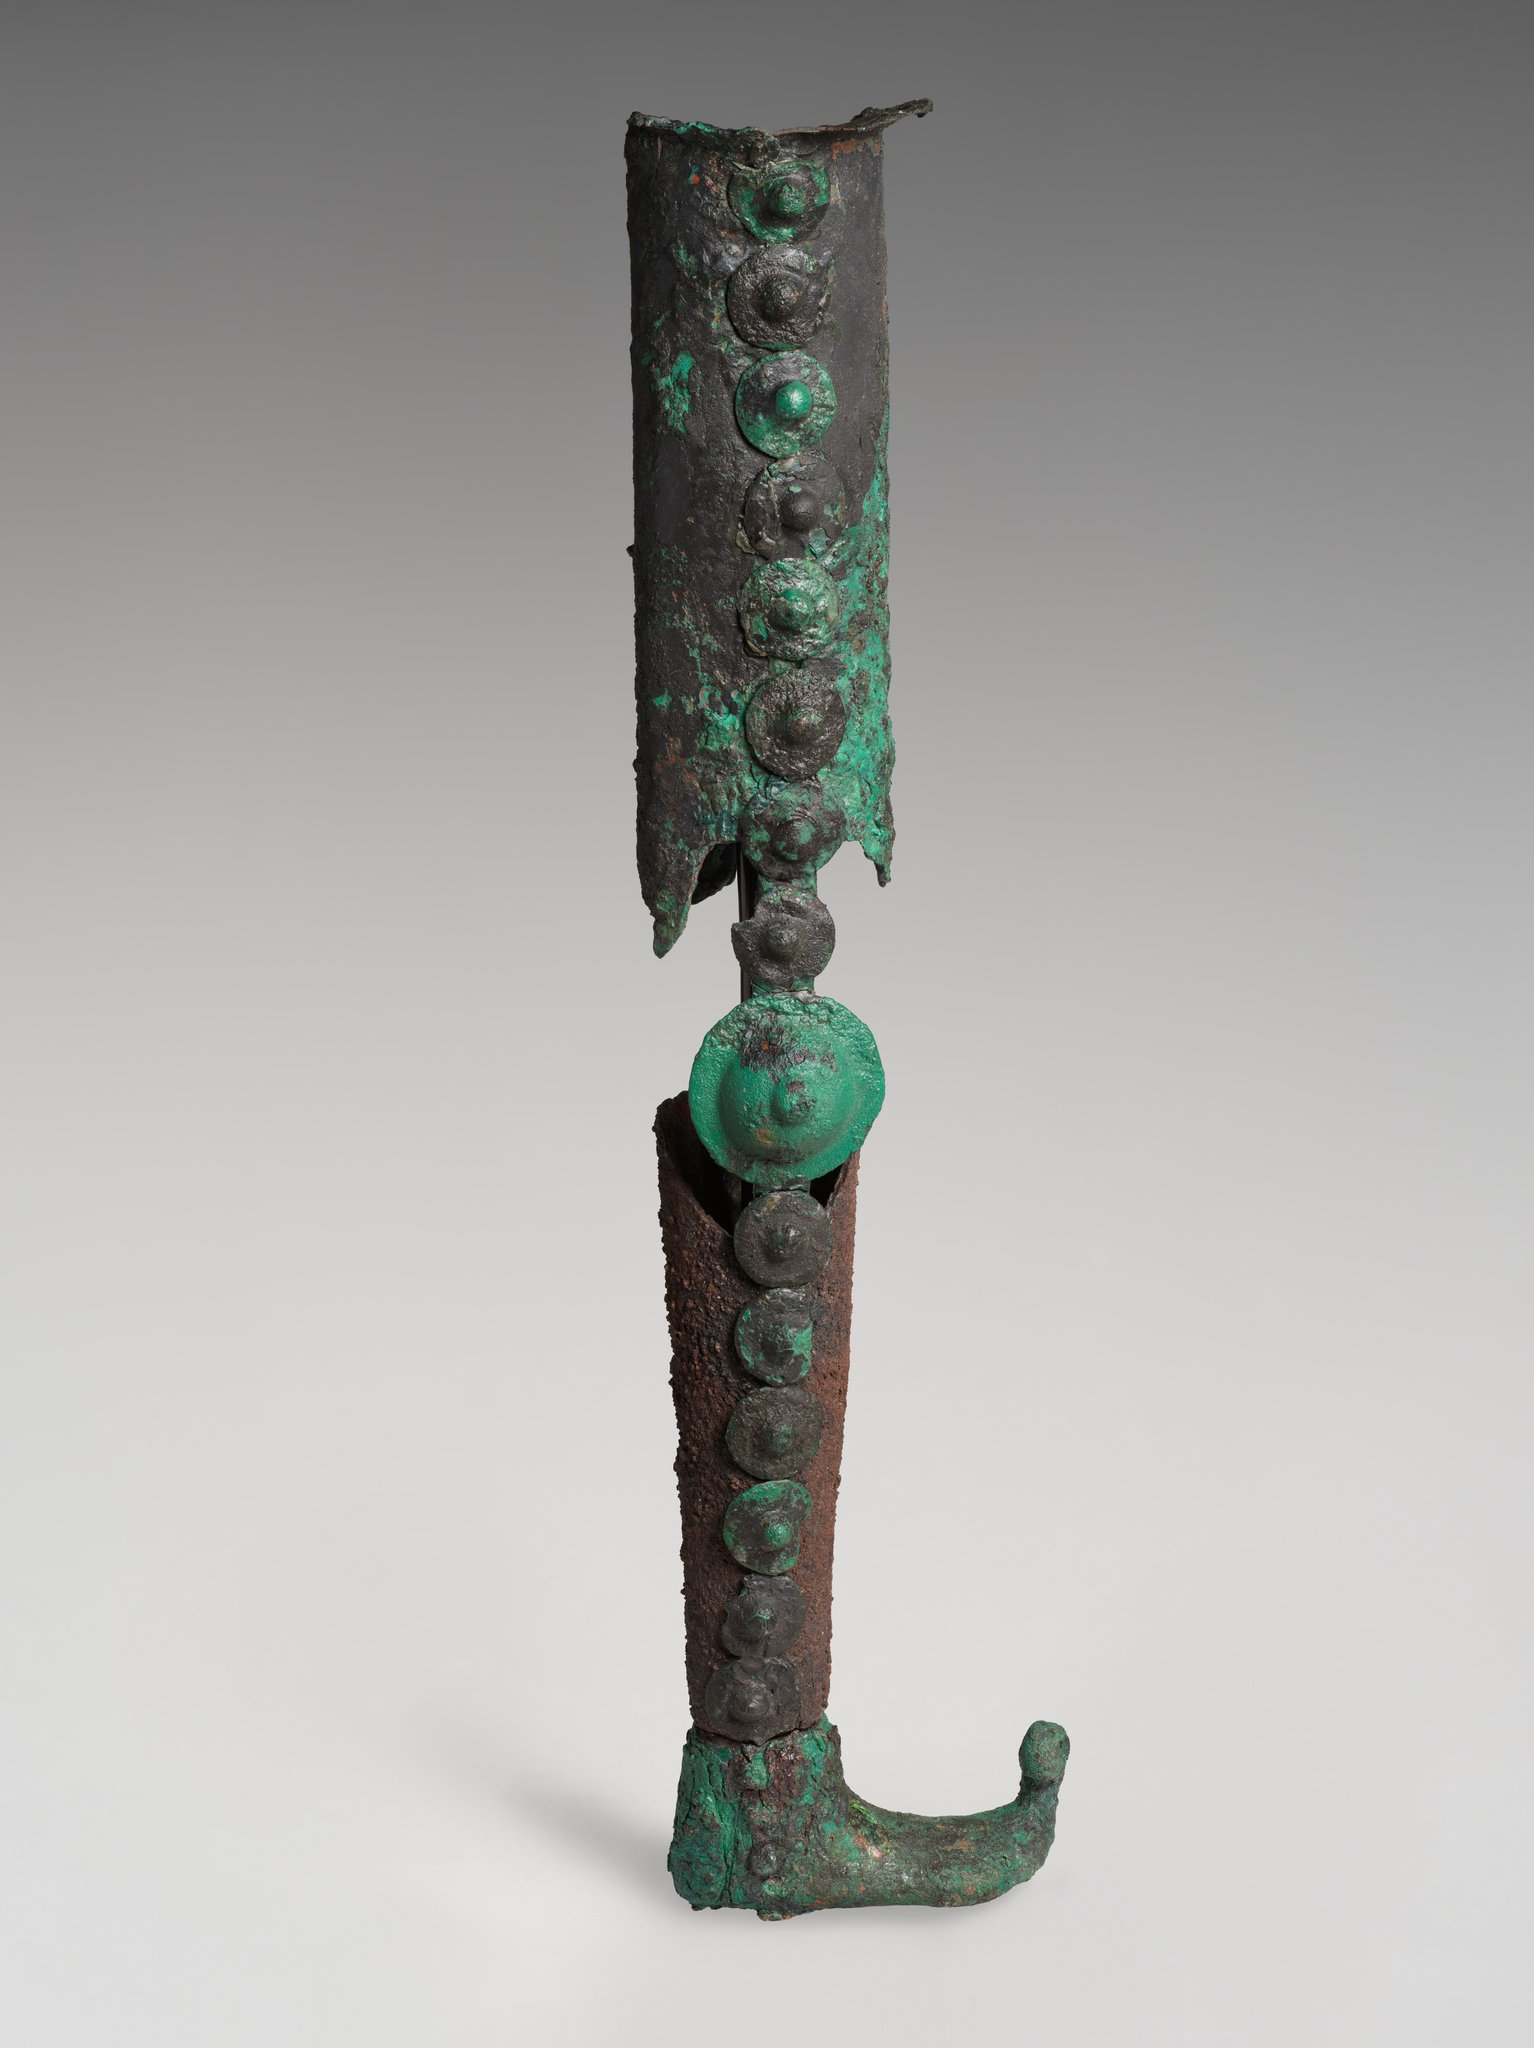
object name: chair or table leg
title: Leg of a chair or table (?)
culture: iranian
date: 900-801 BCE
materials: bronze, iron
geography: iran